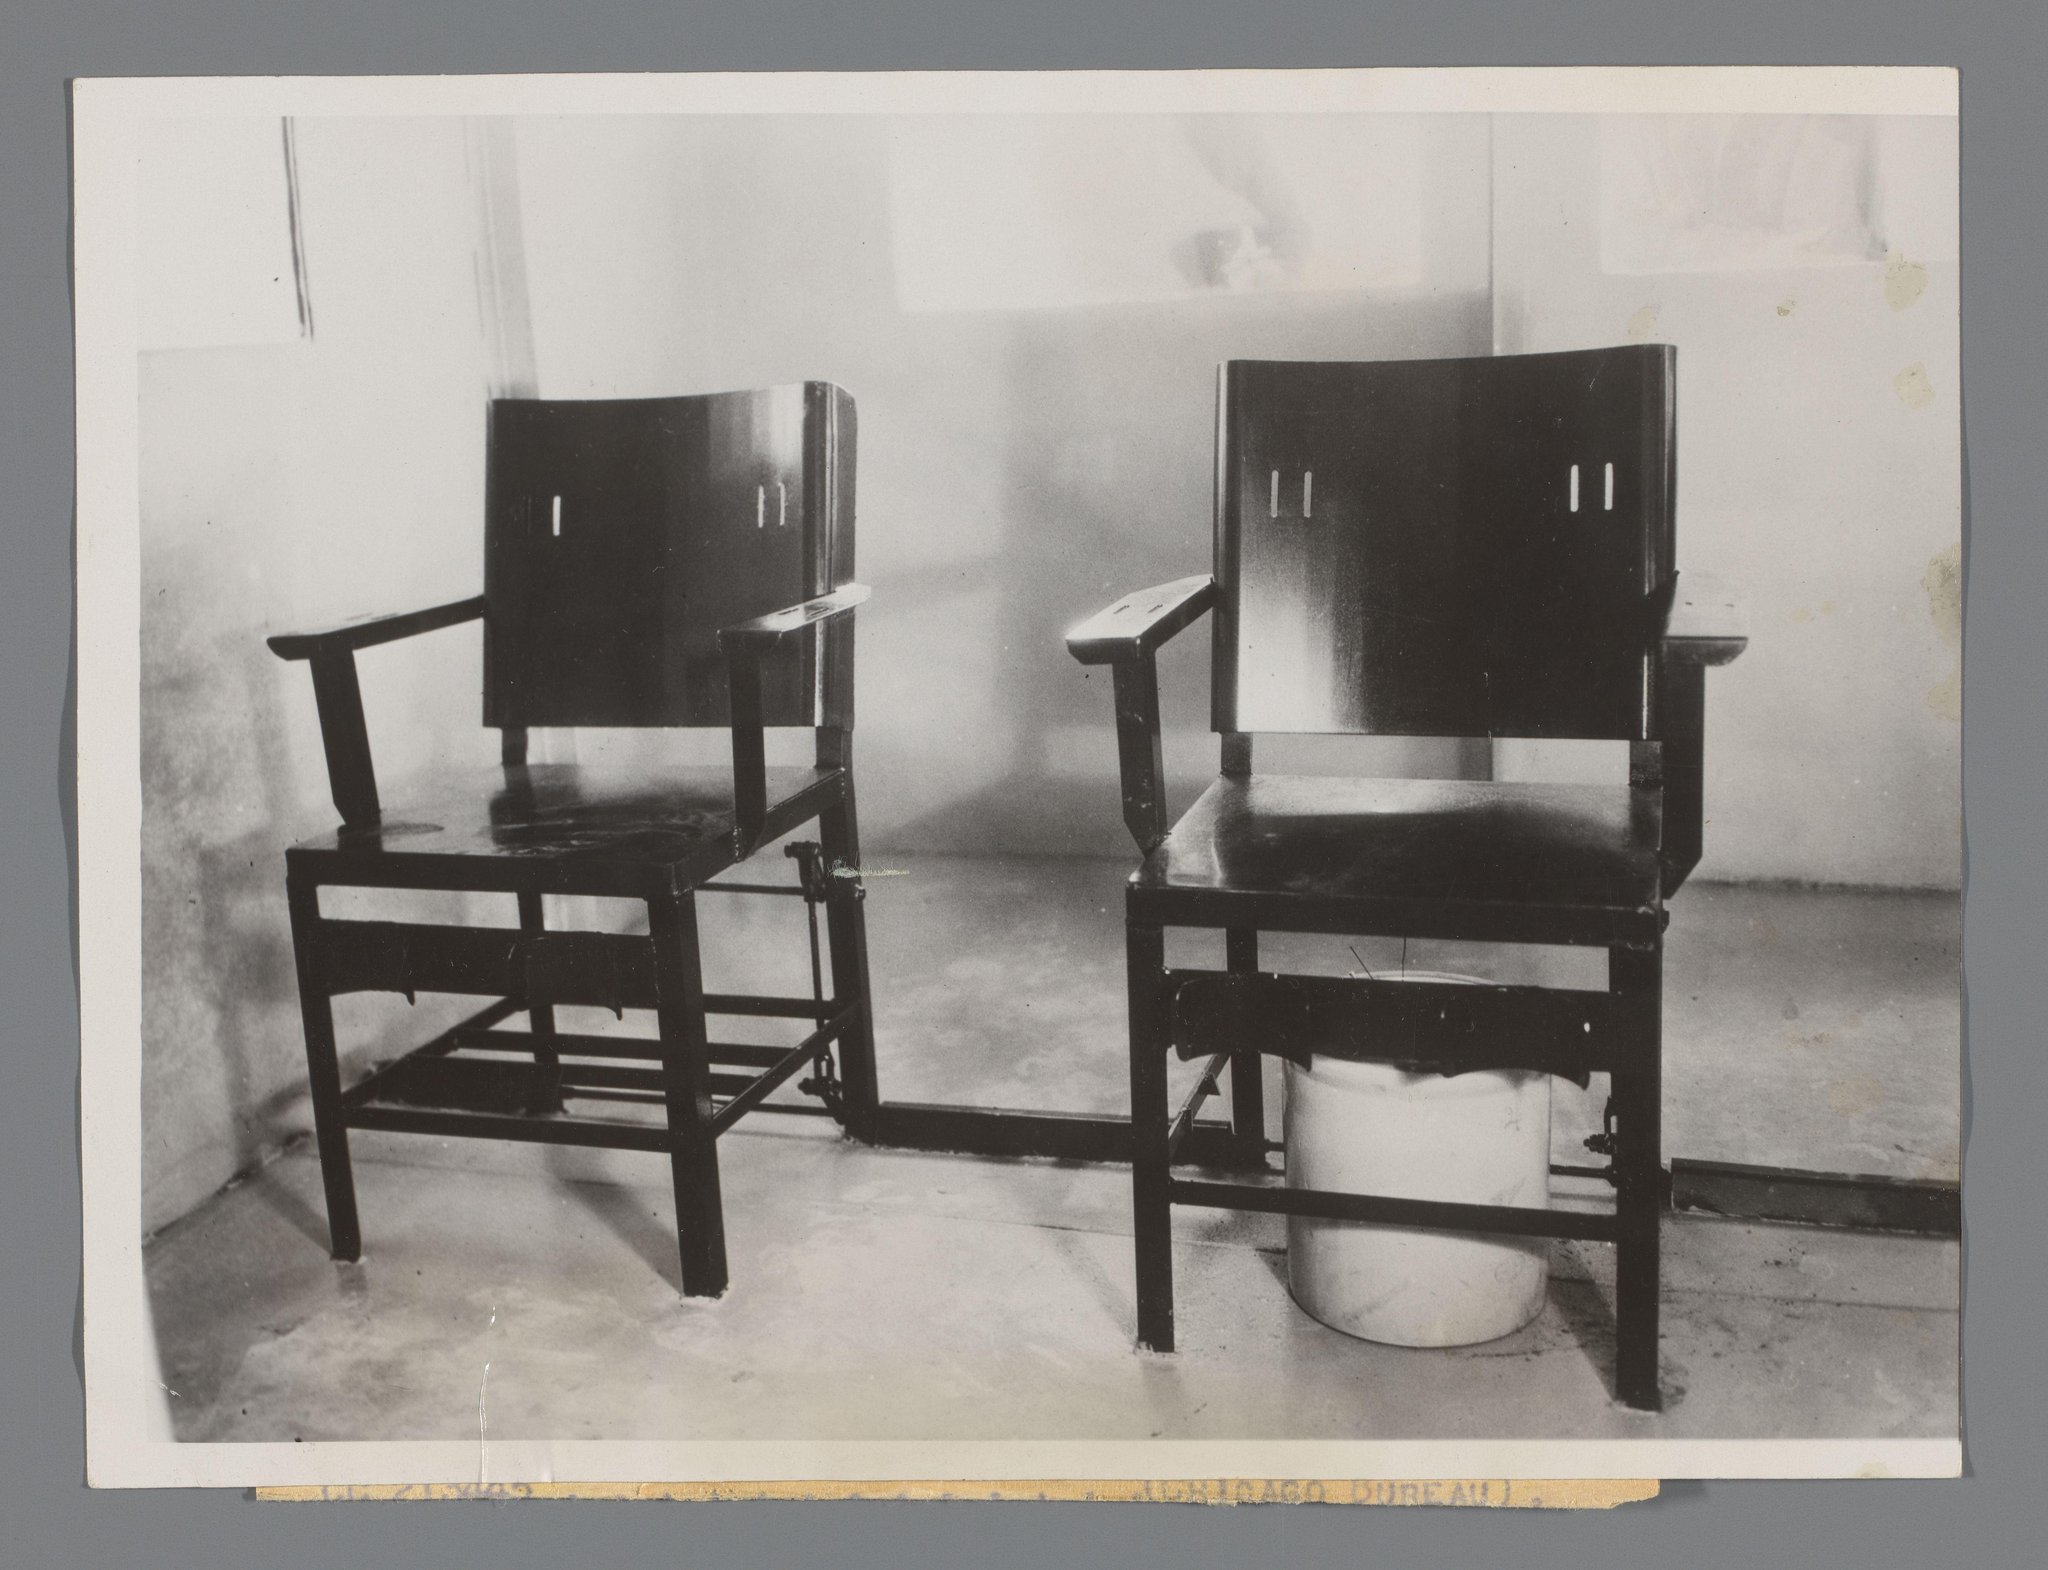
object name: photograph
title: Twee stoelen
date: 1933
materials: photographic support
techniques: gelatin silver print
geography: united states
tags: colorado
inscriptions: label: ‘THE ONLY FURNITURE IN THE CHAMBER OF THE COLORADO STATE PENITENTIARY AT CANON CITY IN WHICH FUTURE EXECUTIONS WILL BE MADE BY GAS’, inscription: ‘Capital Punishment’, stamp: ‘PHOTO / BY ACME NEWSPICTURES, Inc,...’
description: Twee stoelen in de ruimte in de Colorado State Penitentiary, Canon City, waar in de toekomst de doodstraf door vergassing zal plaatsvinden.